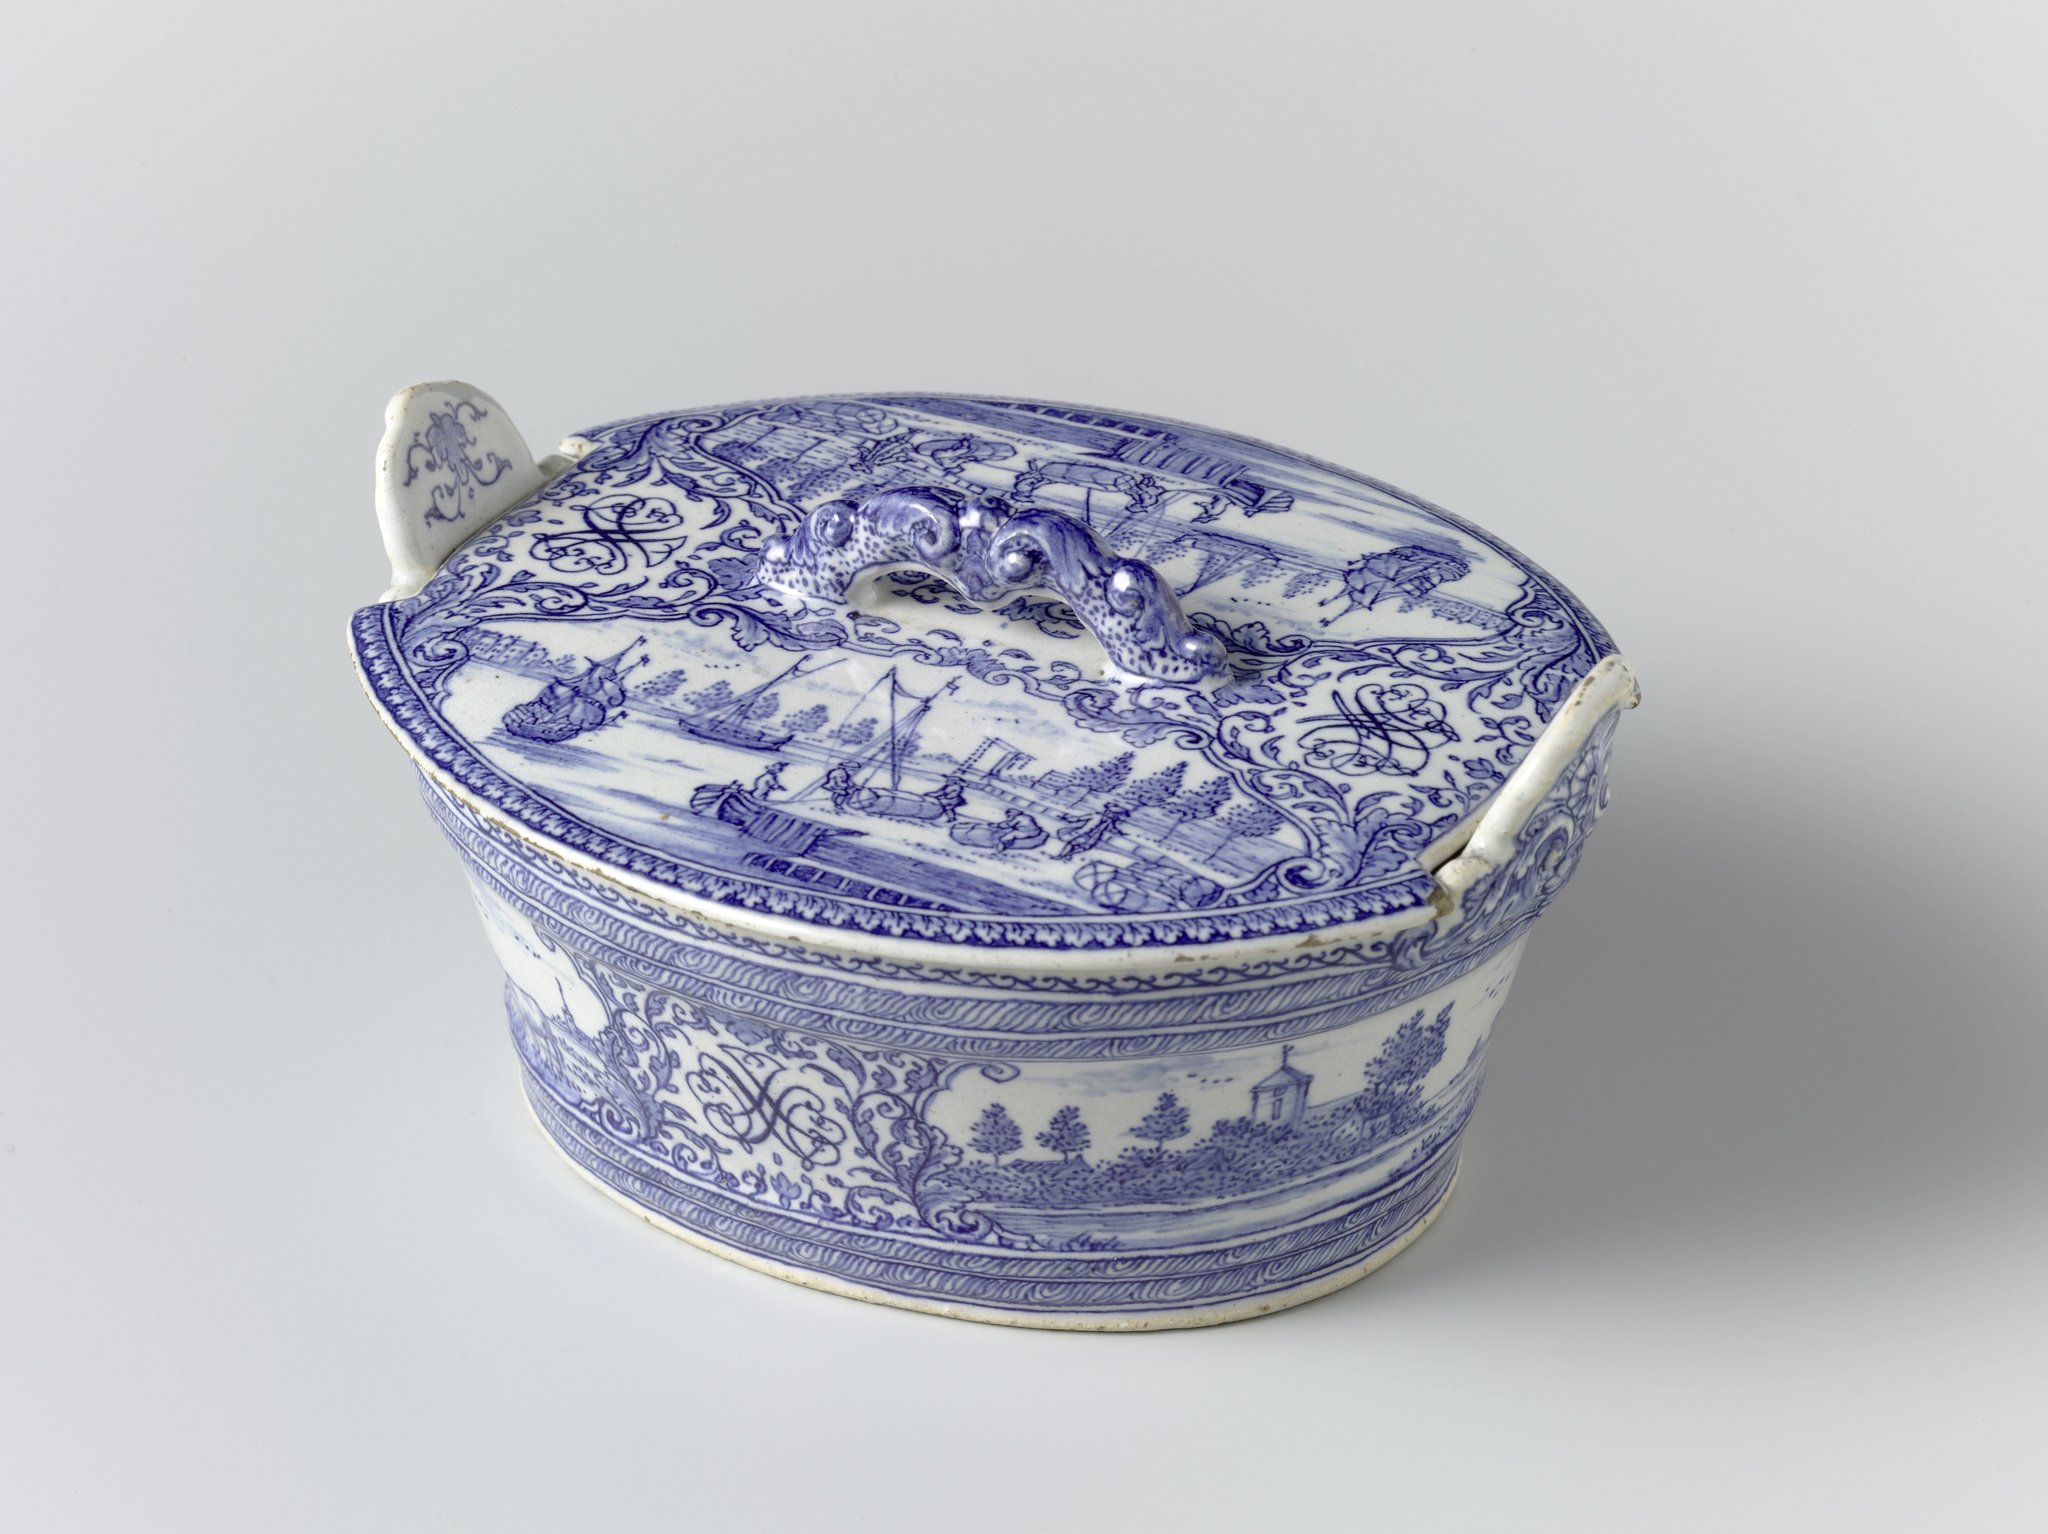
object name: butter dish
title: Two butter dishes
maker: Anonymous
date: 1750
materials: earthenware, glaze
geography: delft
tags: landscapes in the temperate zone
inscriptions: date: ‘1750’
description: Botervloot met deksel van faïence, ovaal. In blauw beschilderd met landschappen en een spiegelmonogram.